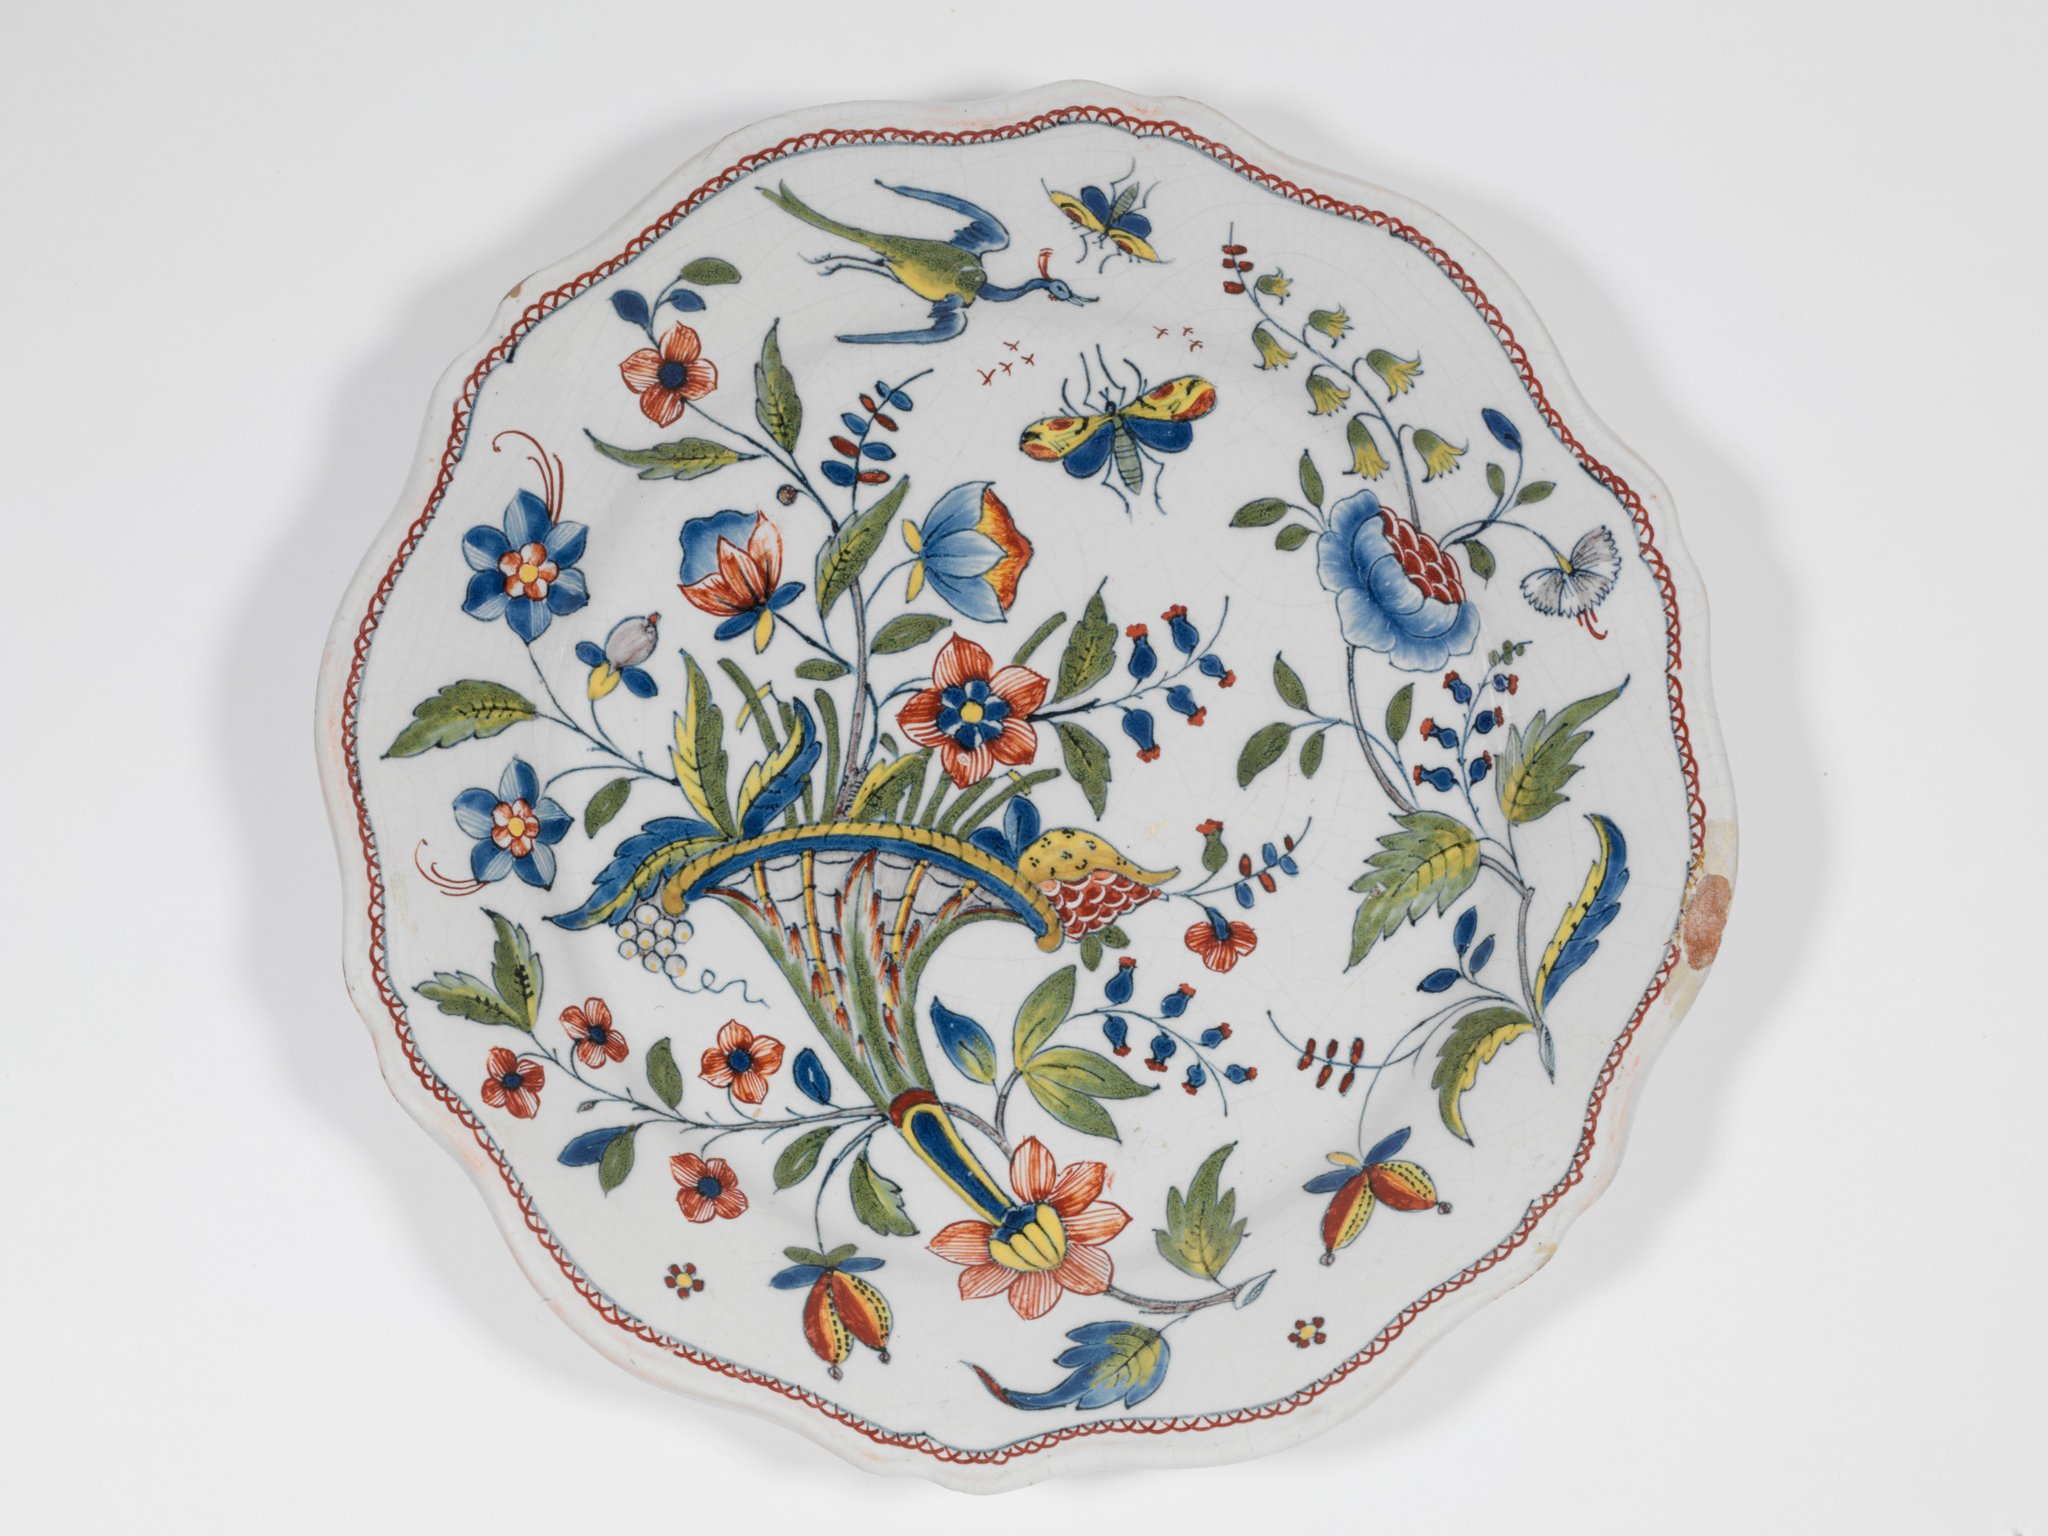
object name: plate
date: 1750-1760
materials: faience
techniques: glazing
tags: birds,insects,flowers